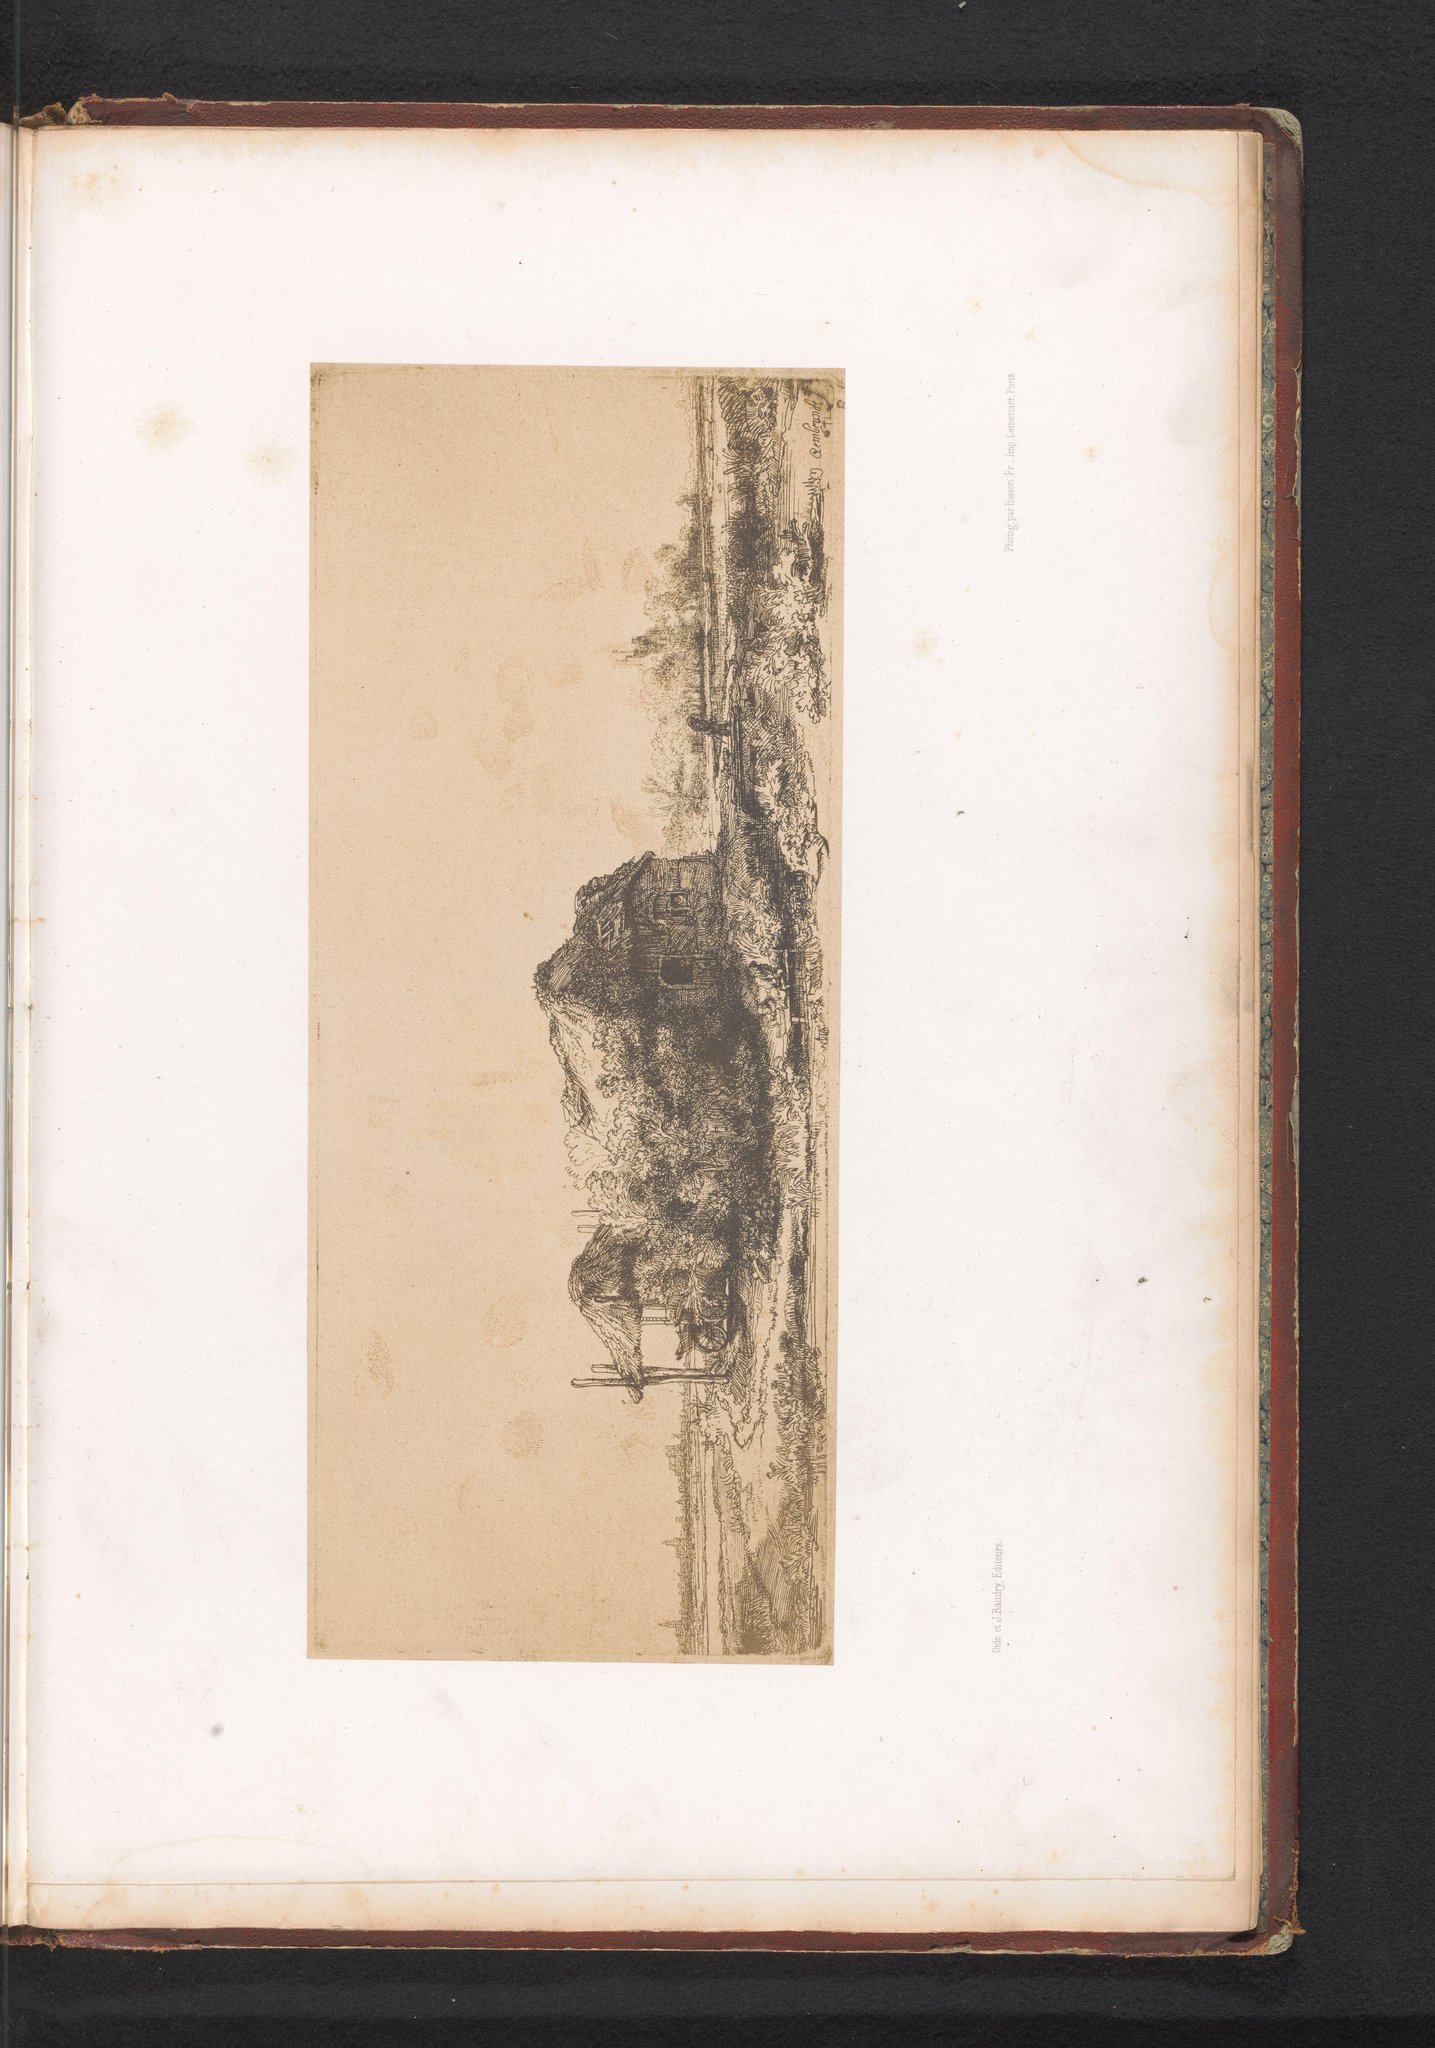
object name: photograph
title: Fotoreproductie van een ets van een boerderij met hooiberg door Rembrandt van Rijn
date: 1848-1853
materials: photographic support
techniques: salted paper print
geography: paris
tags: hay-stack, farm or solitary house in landscape